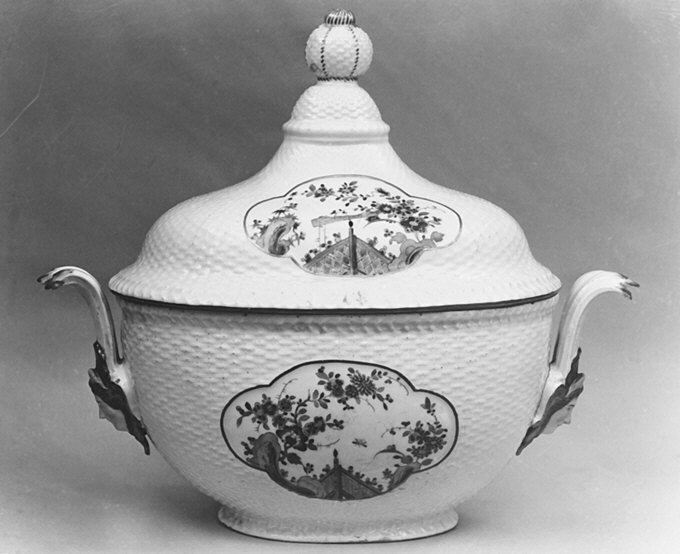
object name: tureen with cover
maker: meissen manufactory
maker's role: manufactory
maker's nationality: german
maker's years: 1710-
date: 1740-1745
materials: hard paste porcelain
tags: flowers